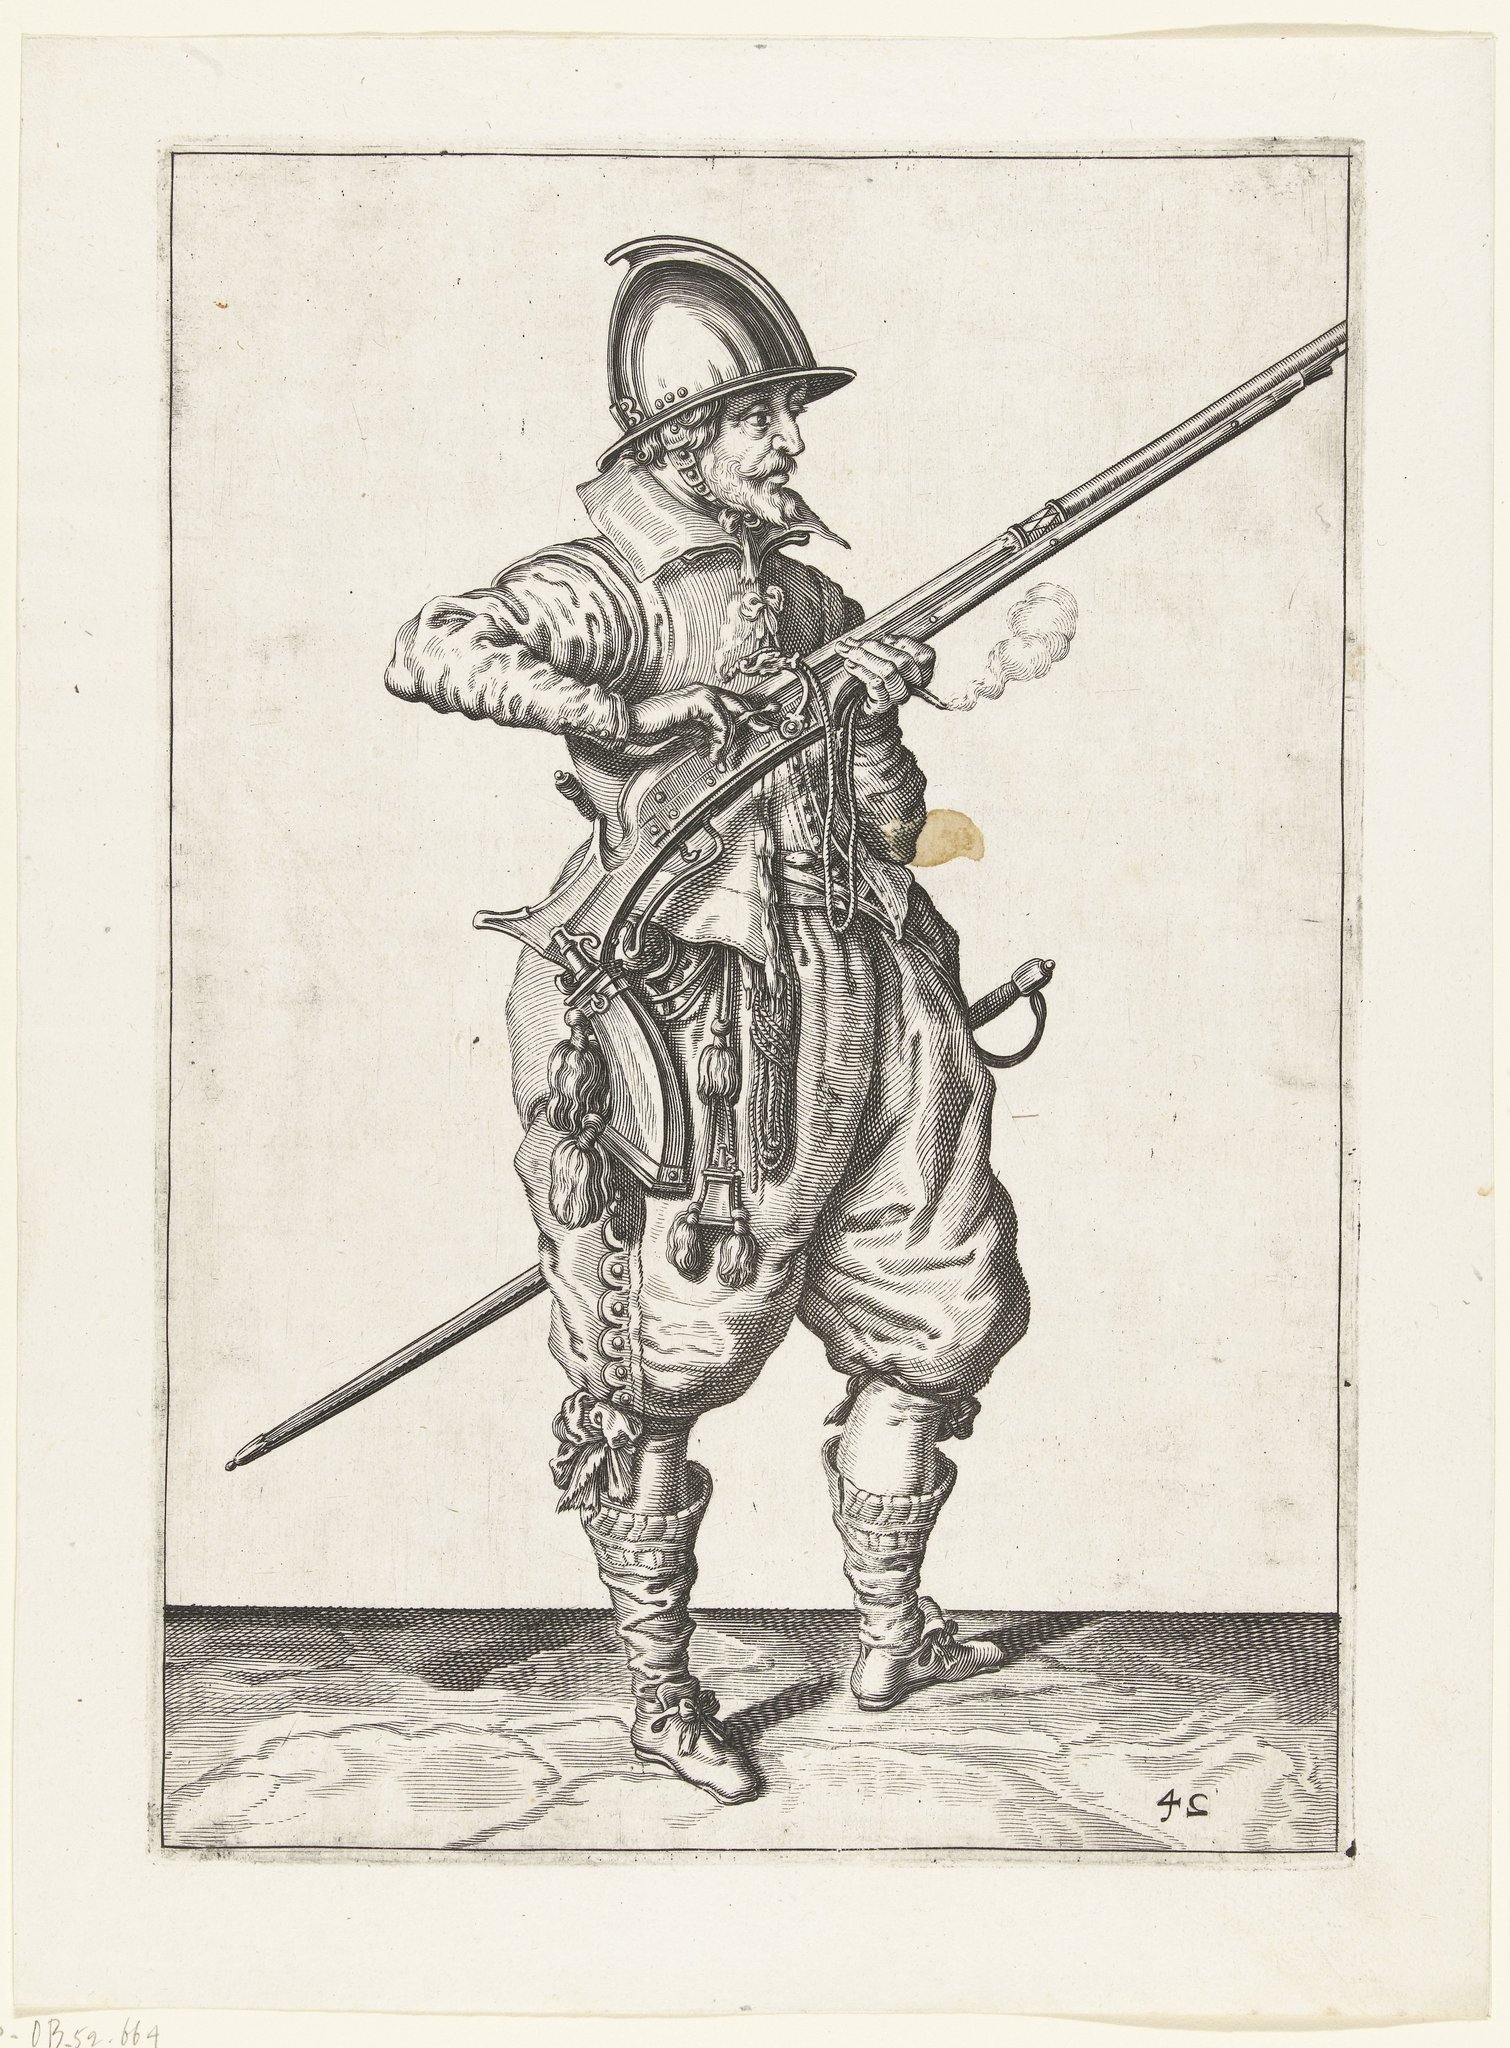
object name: print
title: Wapenhandelinghe van Roers Musquetten ende Spiessen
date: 1597-1607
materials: paper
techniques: engraving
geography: netherlands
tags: manoeuvre ~ military training, firearms: rifle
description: Een soldaat op wacht, ten voeten uit, naar rechts, die een roer (een bepaald type vuurwapen) met zijn linkerhand vasthoudt. Op de haan (onderdeel van het ontstekingsmechanisme) van zijn roer ligt de brandende lont. Met de wijsvinger en de middelvinger van zijn rechterhand bedekt hij de pan (het kruitreservoir) van zijn roer om het kruit te beschermen tegen vonken van de lont. Deze prent is onderdeel van de reeks van 42 genummerde prenten van roerschutters uit de Wapenhandelinghe.